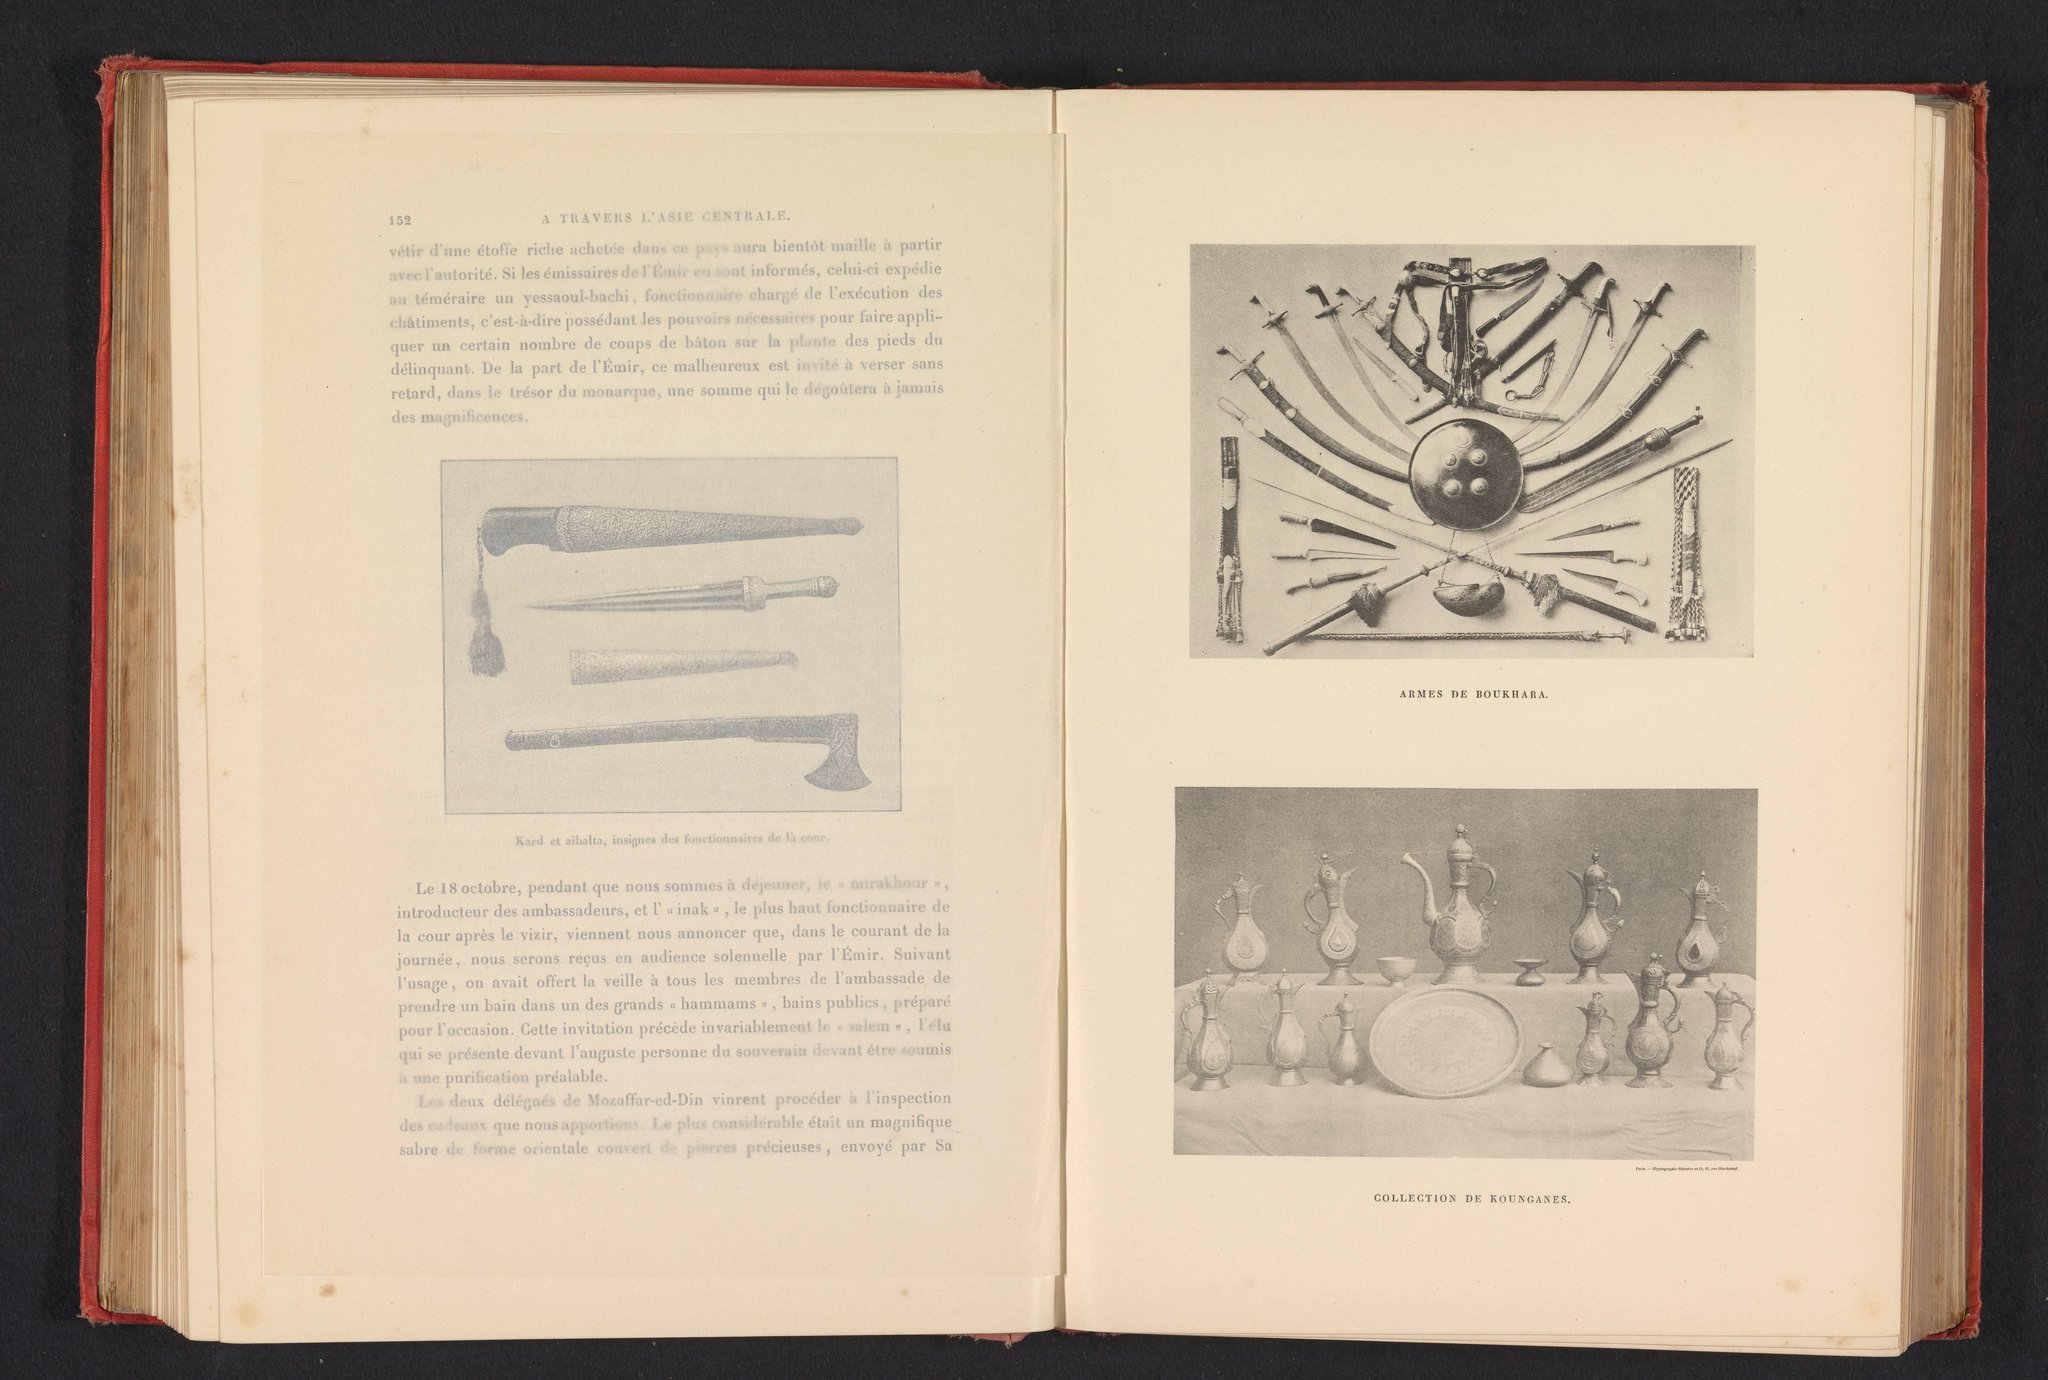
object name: page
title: Twee verzamelingen van objecten uit Centraal-Azië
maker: Anonymous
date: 1869-1885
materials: paper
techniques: photograph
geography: paris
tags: weapons, tea-pot; samovar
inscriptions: name: ‘Silvestre et Cie, 97, rue Oberkampf.’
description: Boven: wapen uit Buchara, onder: theepotten en een dienblad.